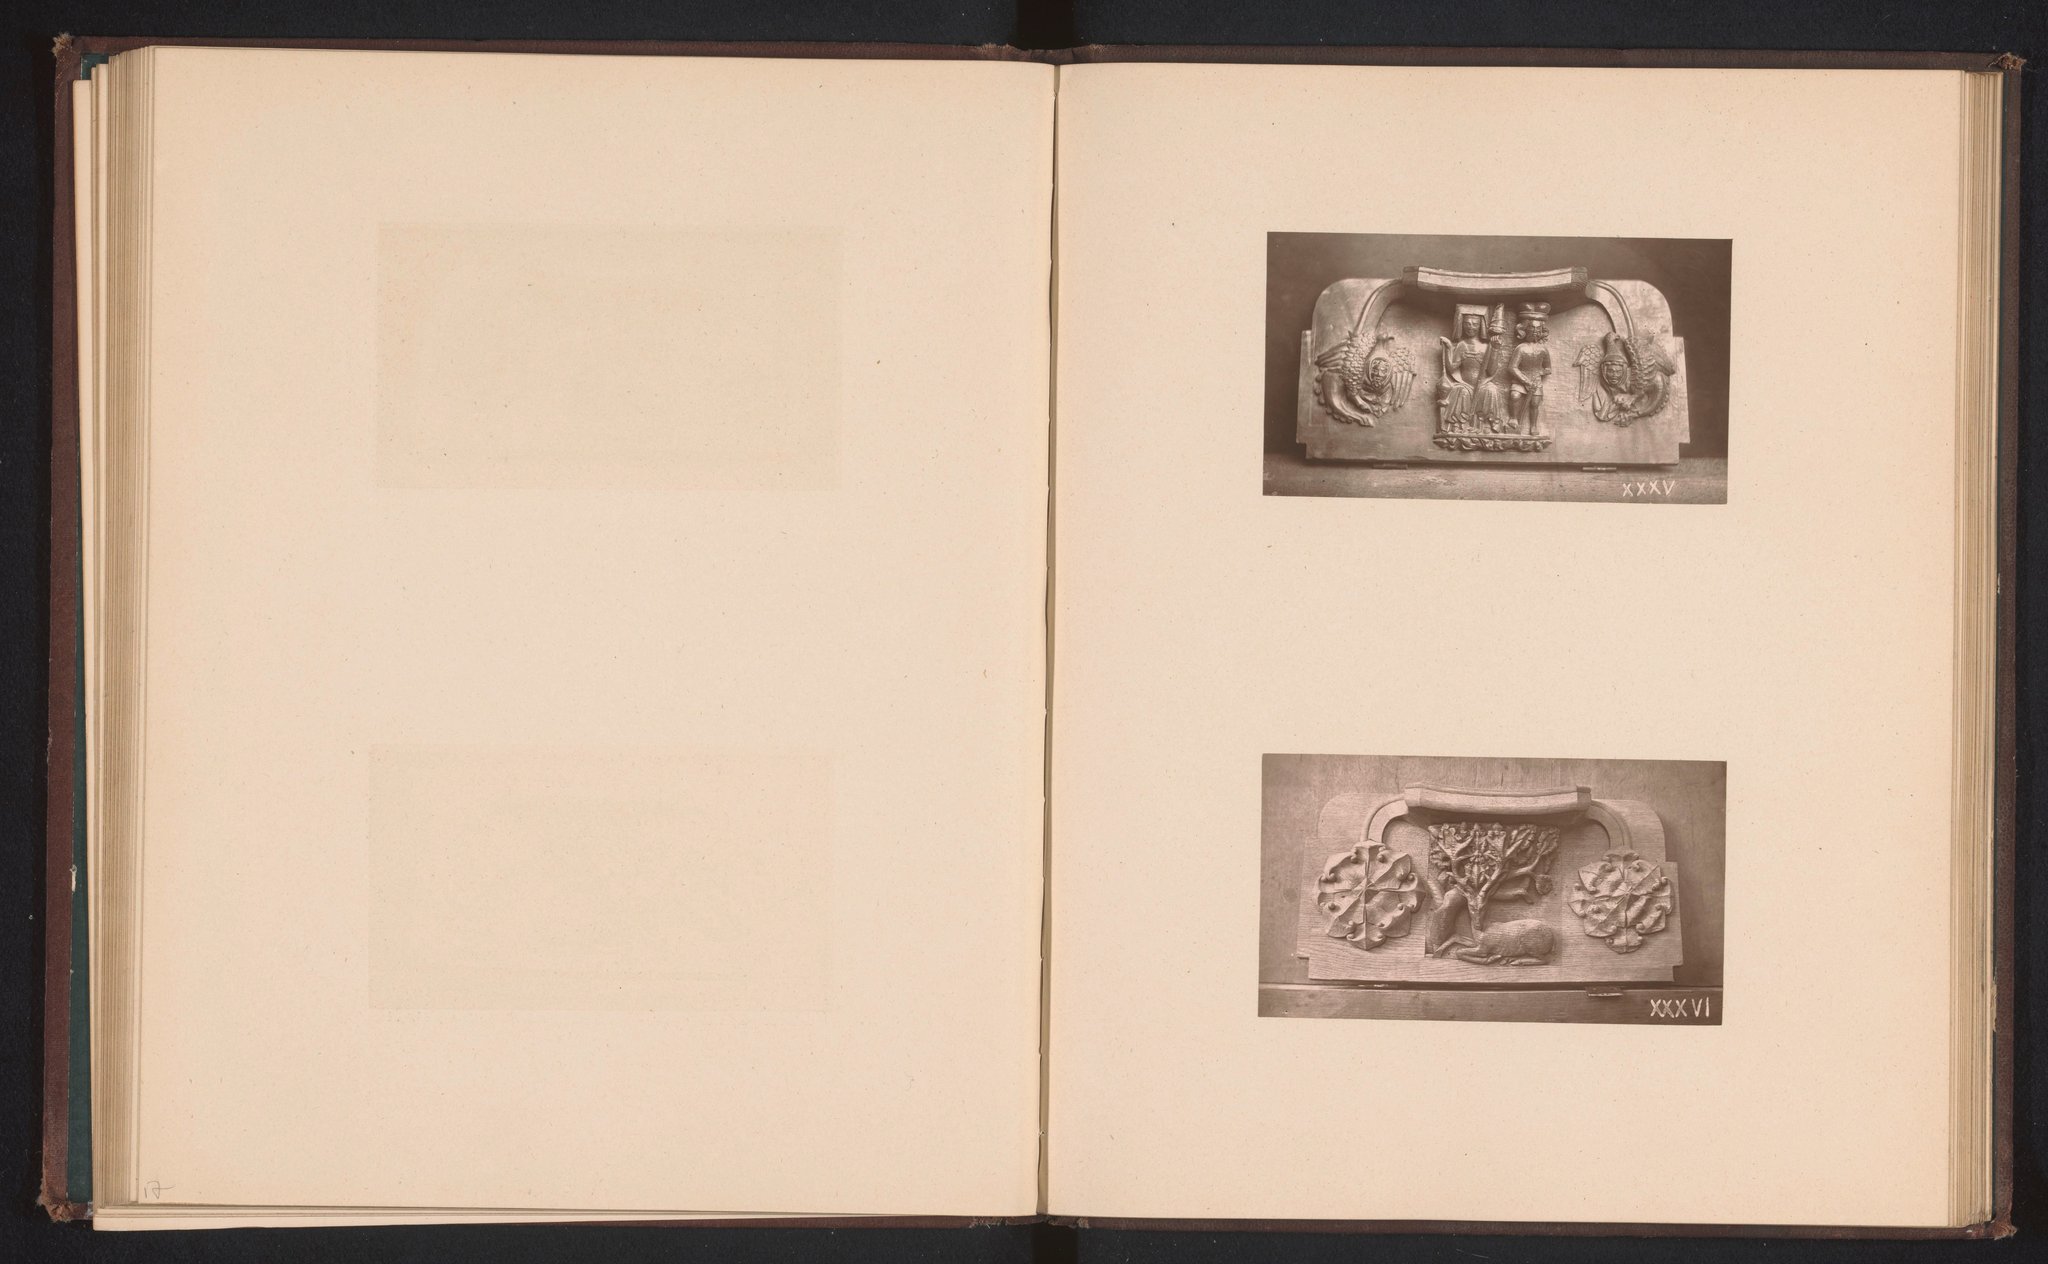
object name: photomechanical print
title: Twee houtsnijwerken in de Kathedraal van Worcester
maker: Anonymous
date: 1863-1873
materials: paper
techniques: woodburytype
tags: carving ~ applied arts, hoofed animals: stag, interior of church, spinning (manufacture of yarn)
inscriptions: number: ‘XXXV (...) XXXVI’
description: Boven een spinnende vrouw en man tussen twee fabelwezens, onder een hert tussen twee bladmotieven.